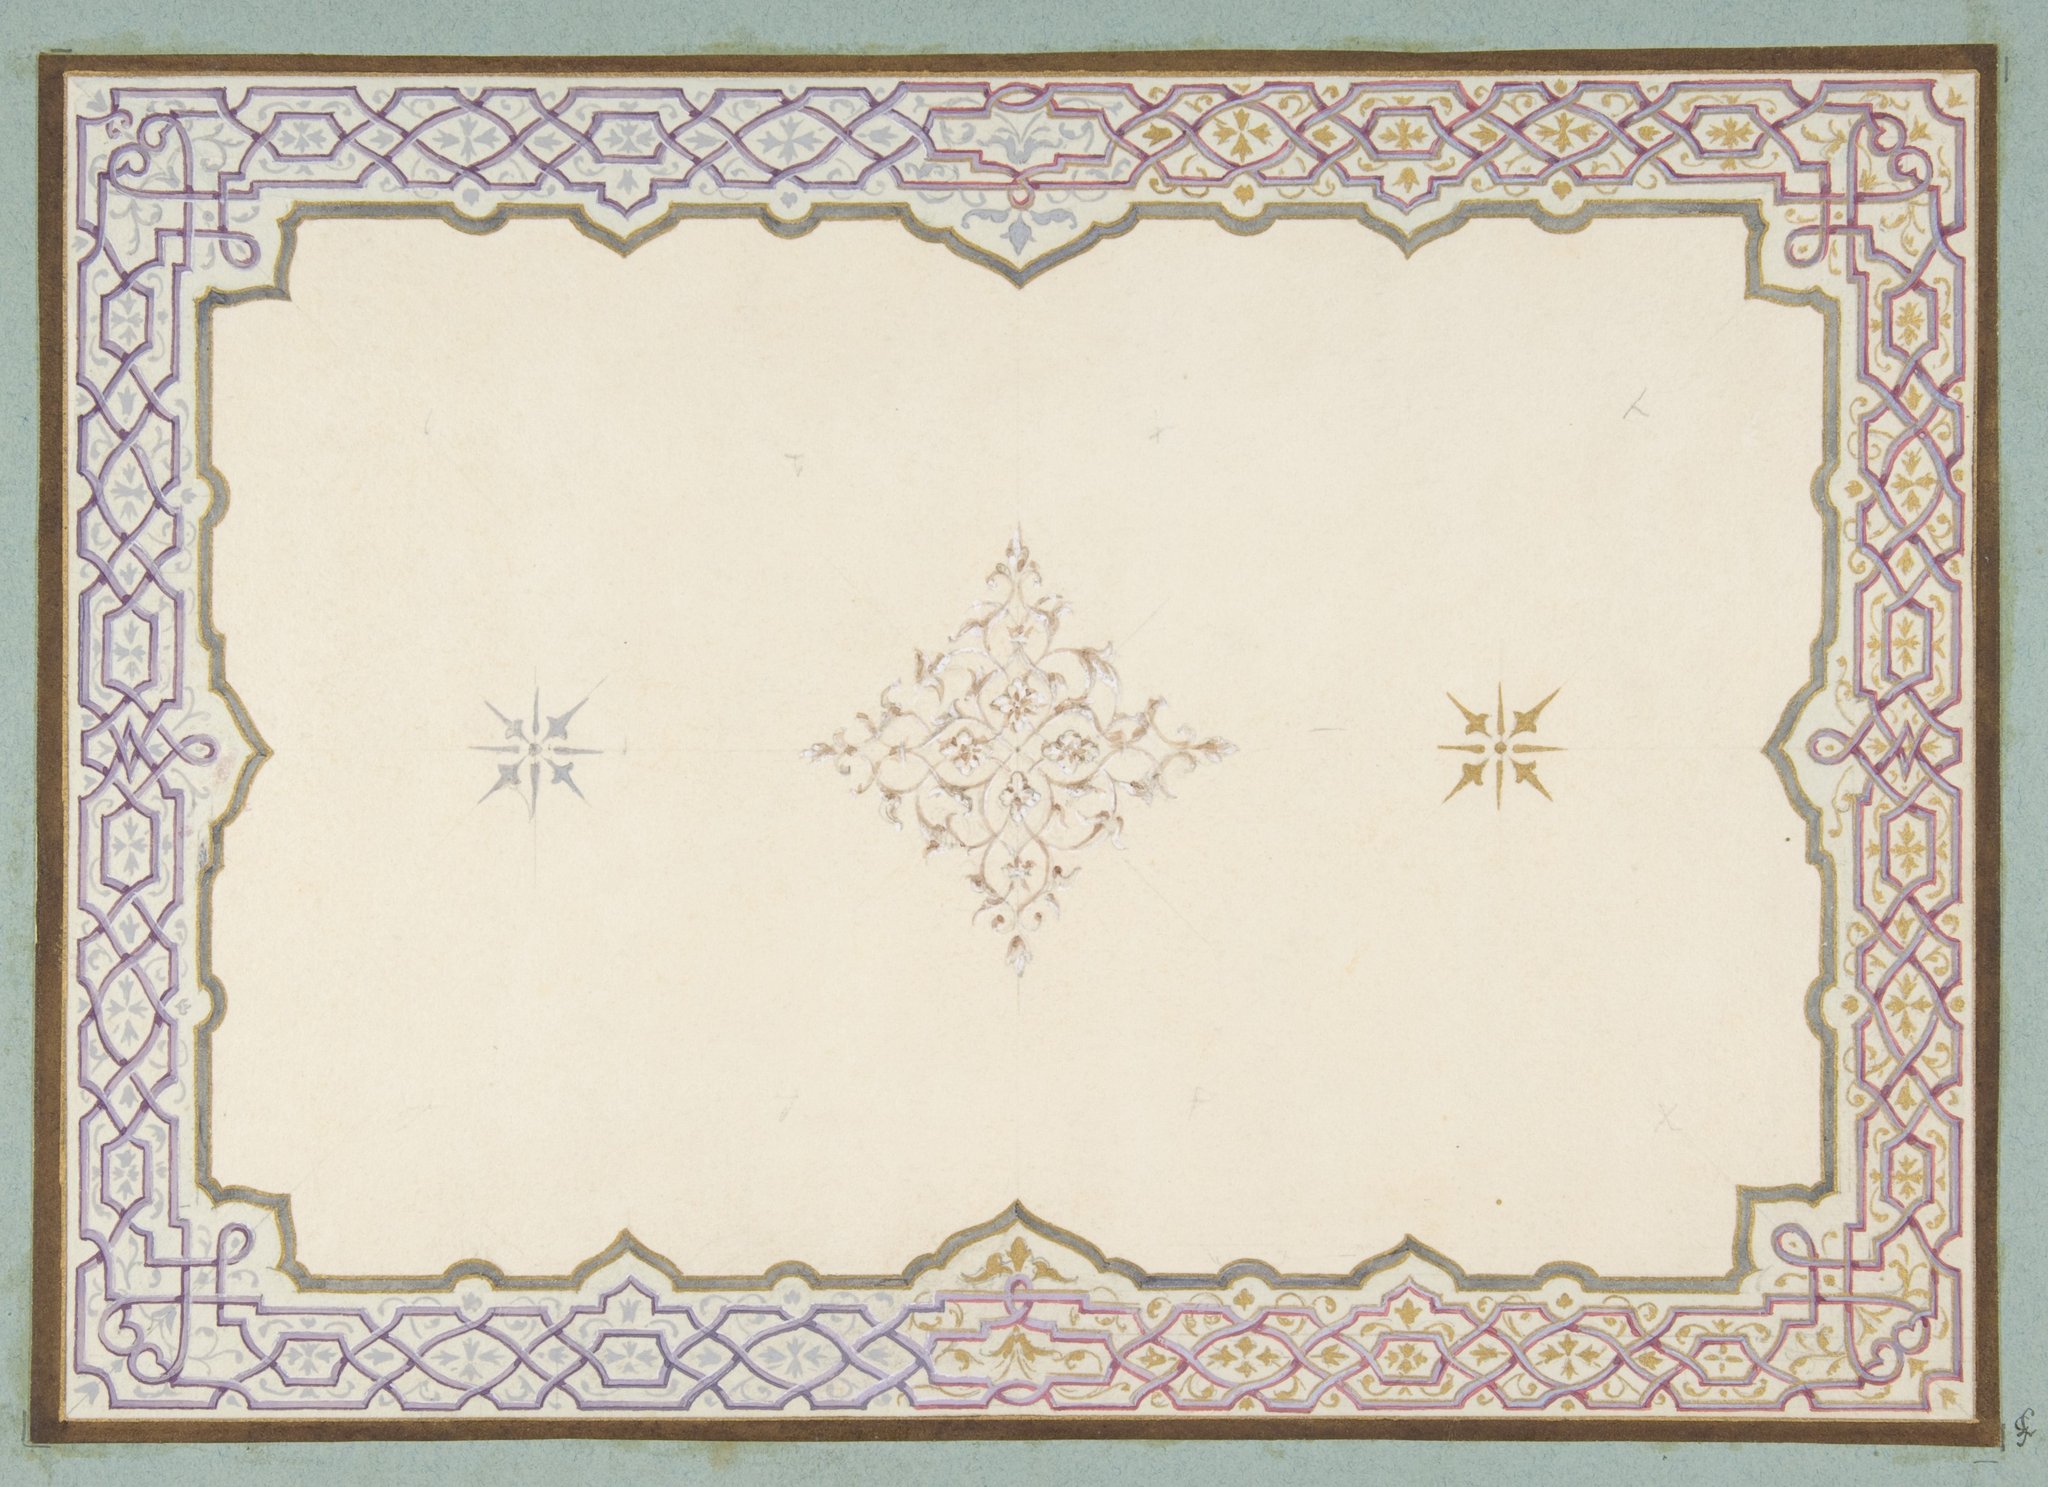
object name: drawing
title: Design for the decoration of a ceiling with a border of strapwork and a central filagree medallion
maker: jules-edmond-charles lachaise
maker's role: artist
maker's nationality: french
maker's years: 1897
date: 1830-1897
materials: gold paint, gouache, watercolor, paper